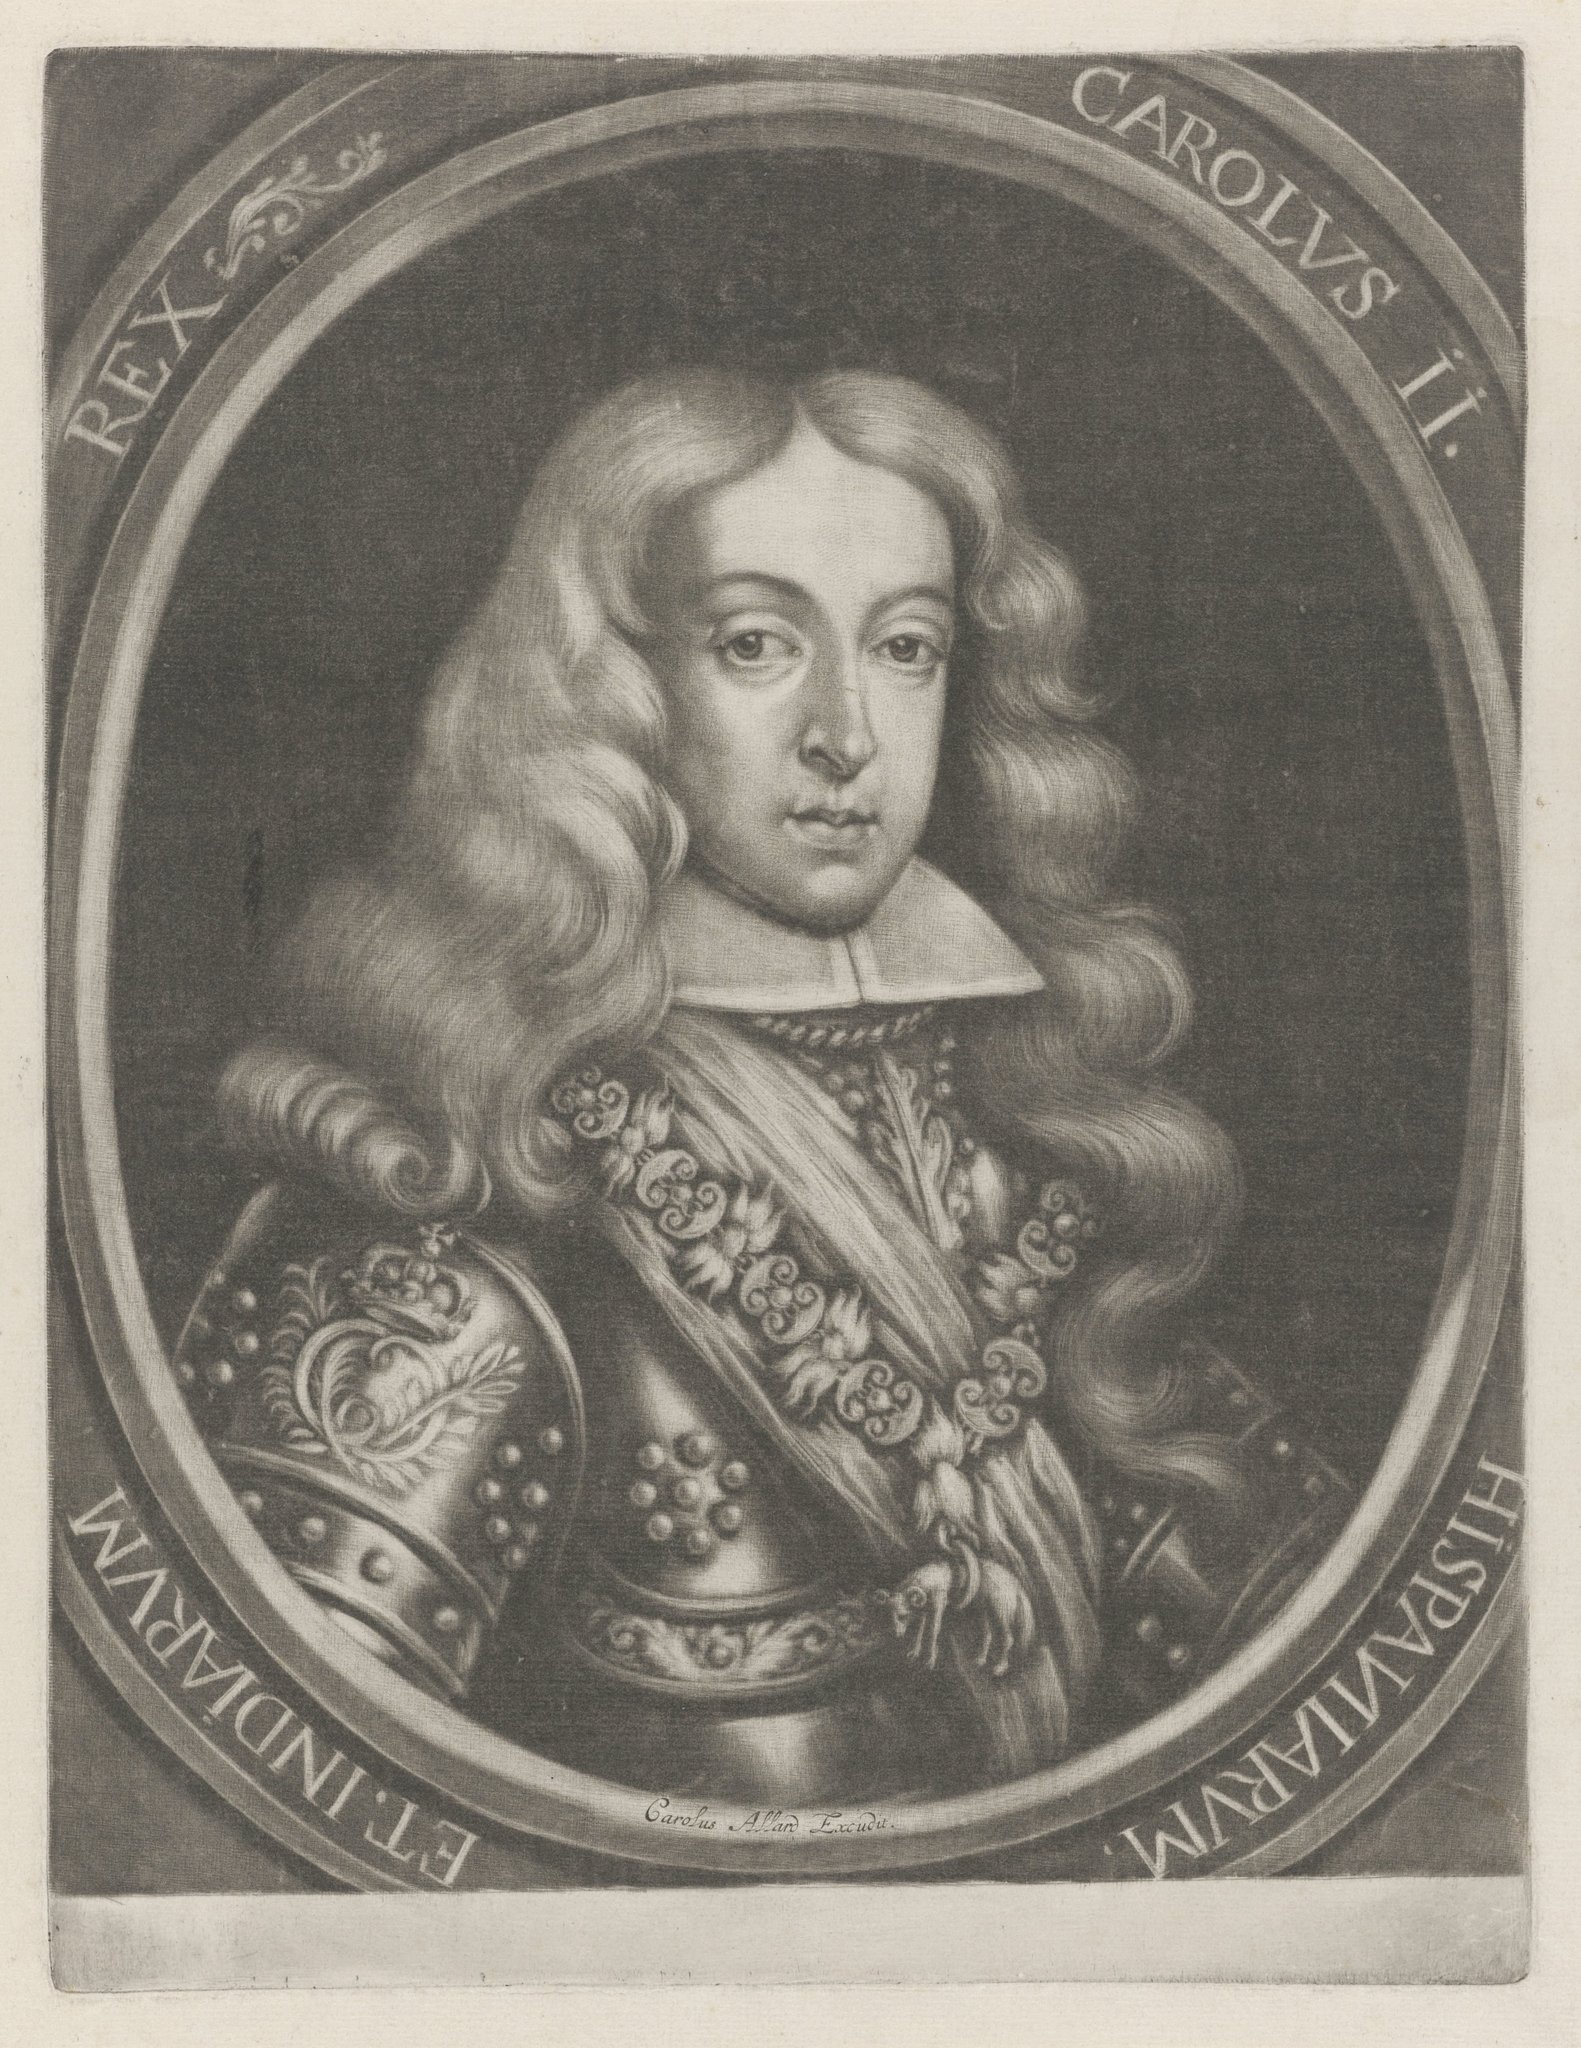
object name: print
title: Portret van Karel II van Spanje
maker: carel allard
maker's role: print maker, publisher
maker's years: 1648-1709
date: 1658-1706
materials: paper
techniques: mezzotint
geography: amsterdam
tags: karel ii (koning van spanje), knighthood order of the golden fleece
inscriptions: collector's mark: Lugt 240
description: Portret van Karel II, koning van Spanje. Om zijn hals de keten met het symbool van de orde van het Gulden Vlies. In de omlijsting de naam en titels van de geportretteerde.